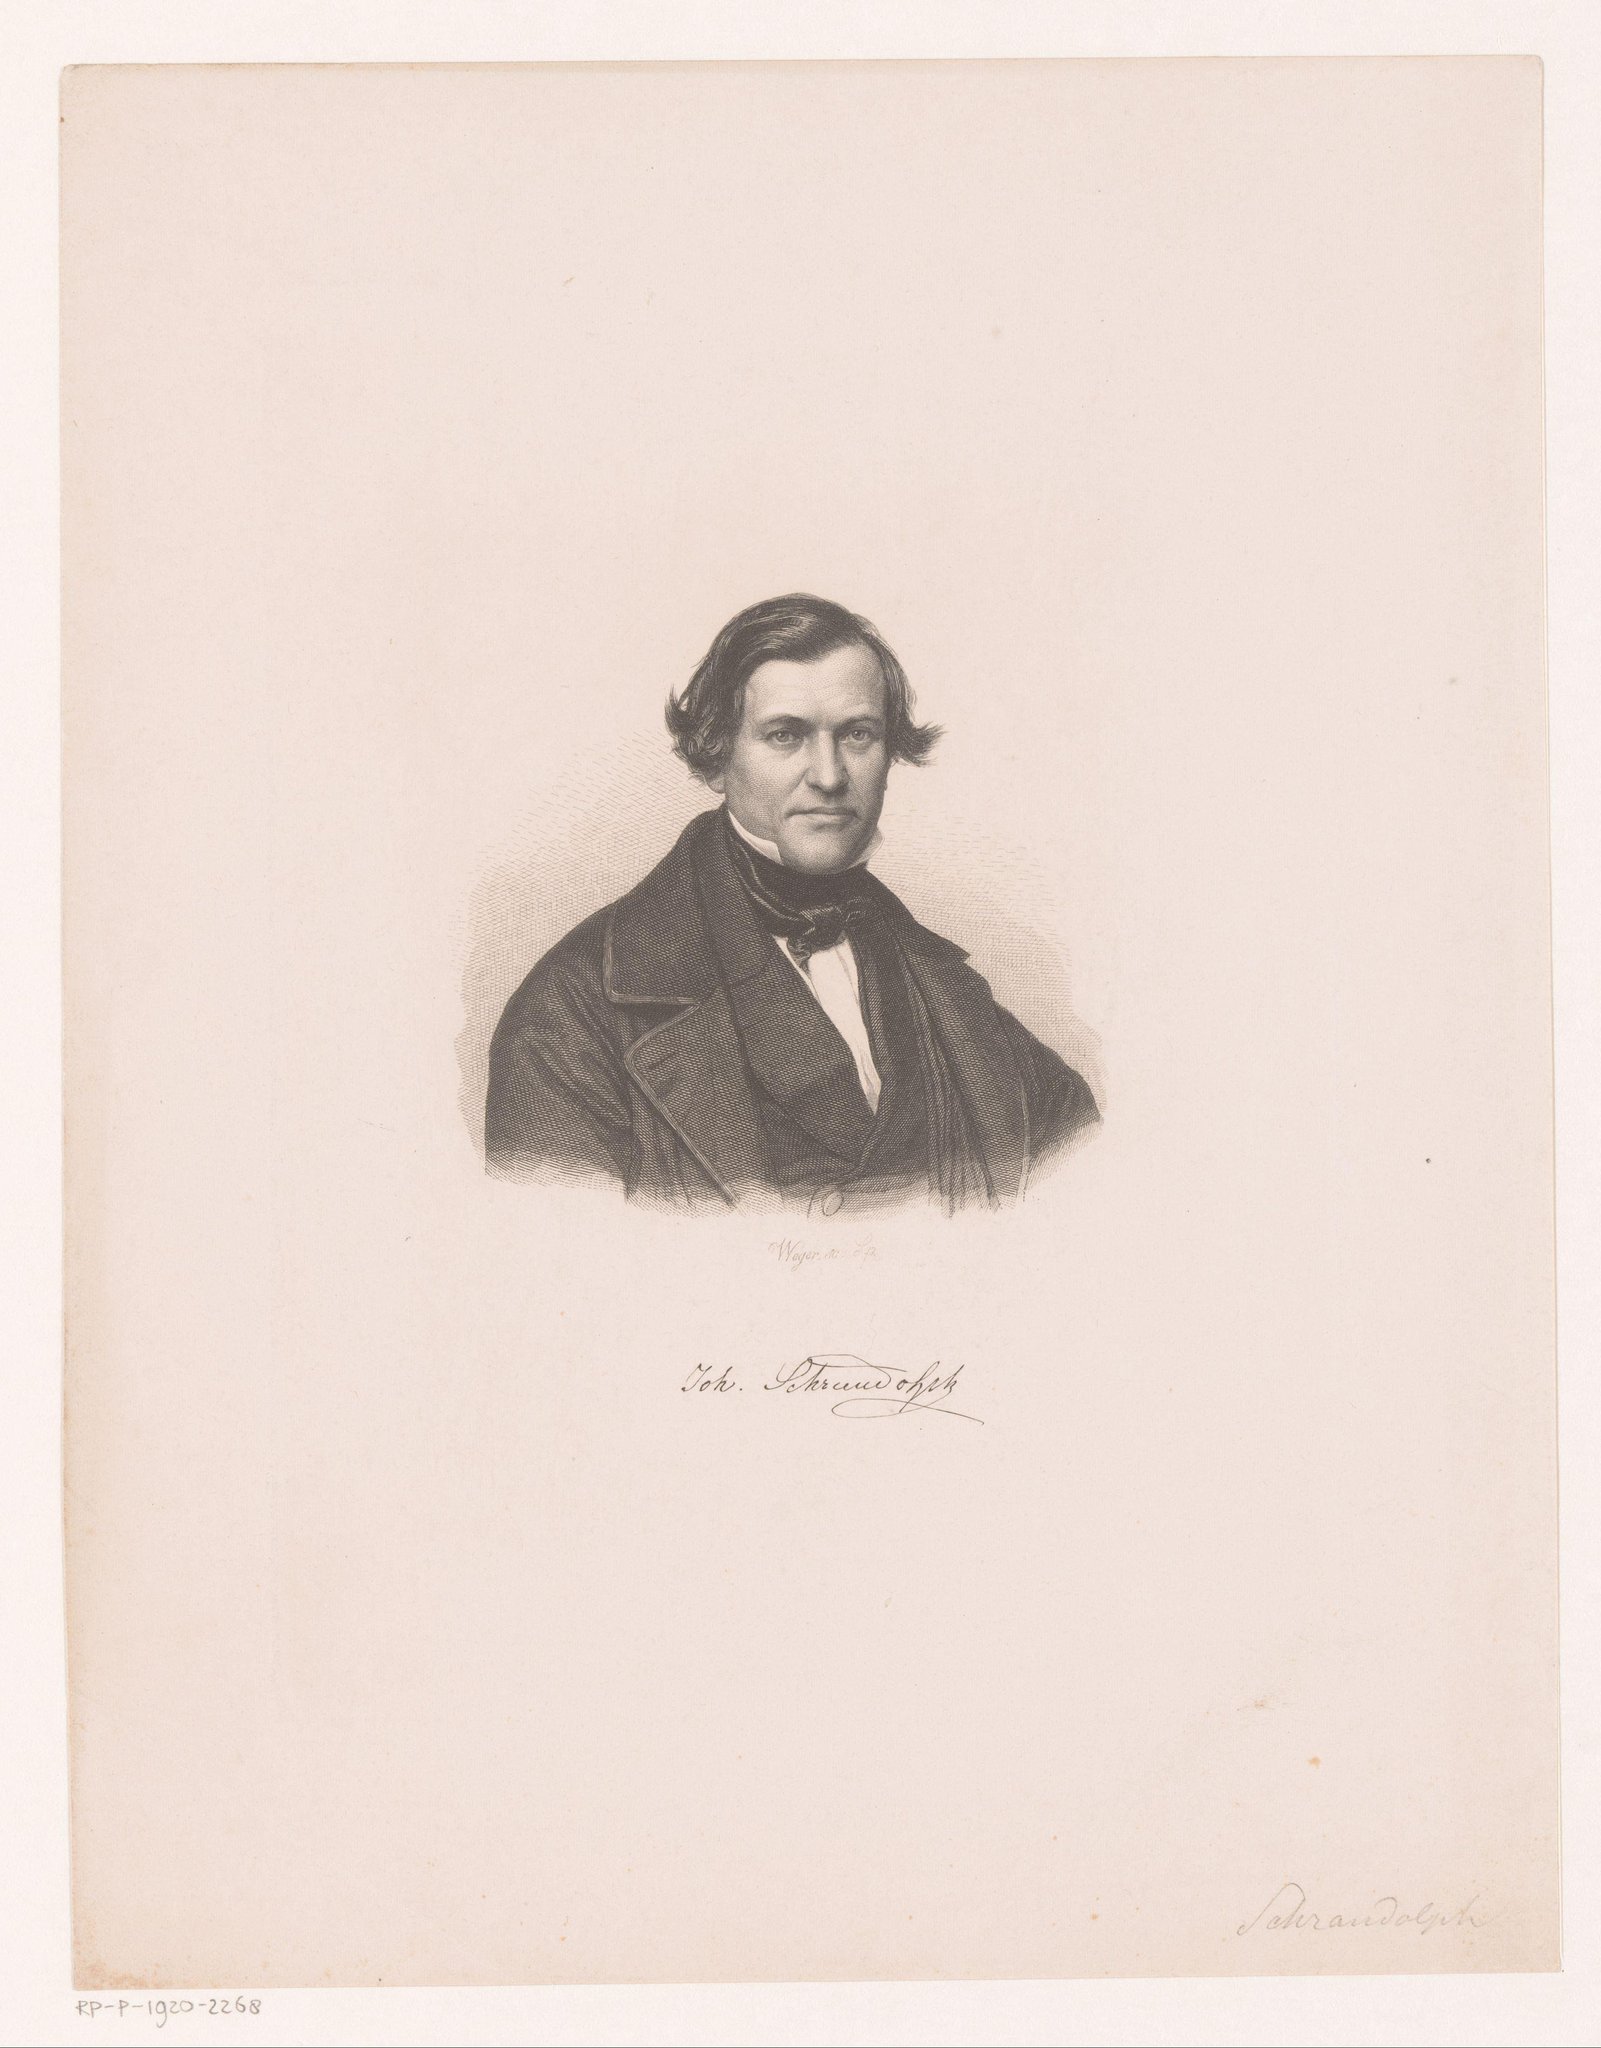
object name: print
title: Portret van Johann van Schraudolph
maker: august weger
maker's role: print maker, printer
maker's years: 1823-1892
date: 1849-1892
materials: paper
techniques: engraving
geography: leipzig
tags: painter, johann van schraudolph, historical persons, portrait, self-portrait of artist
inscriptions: collector's mark: Lugt 2228